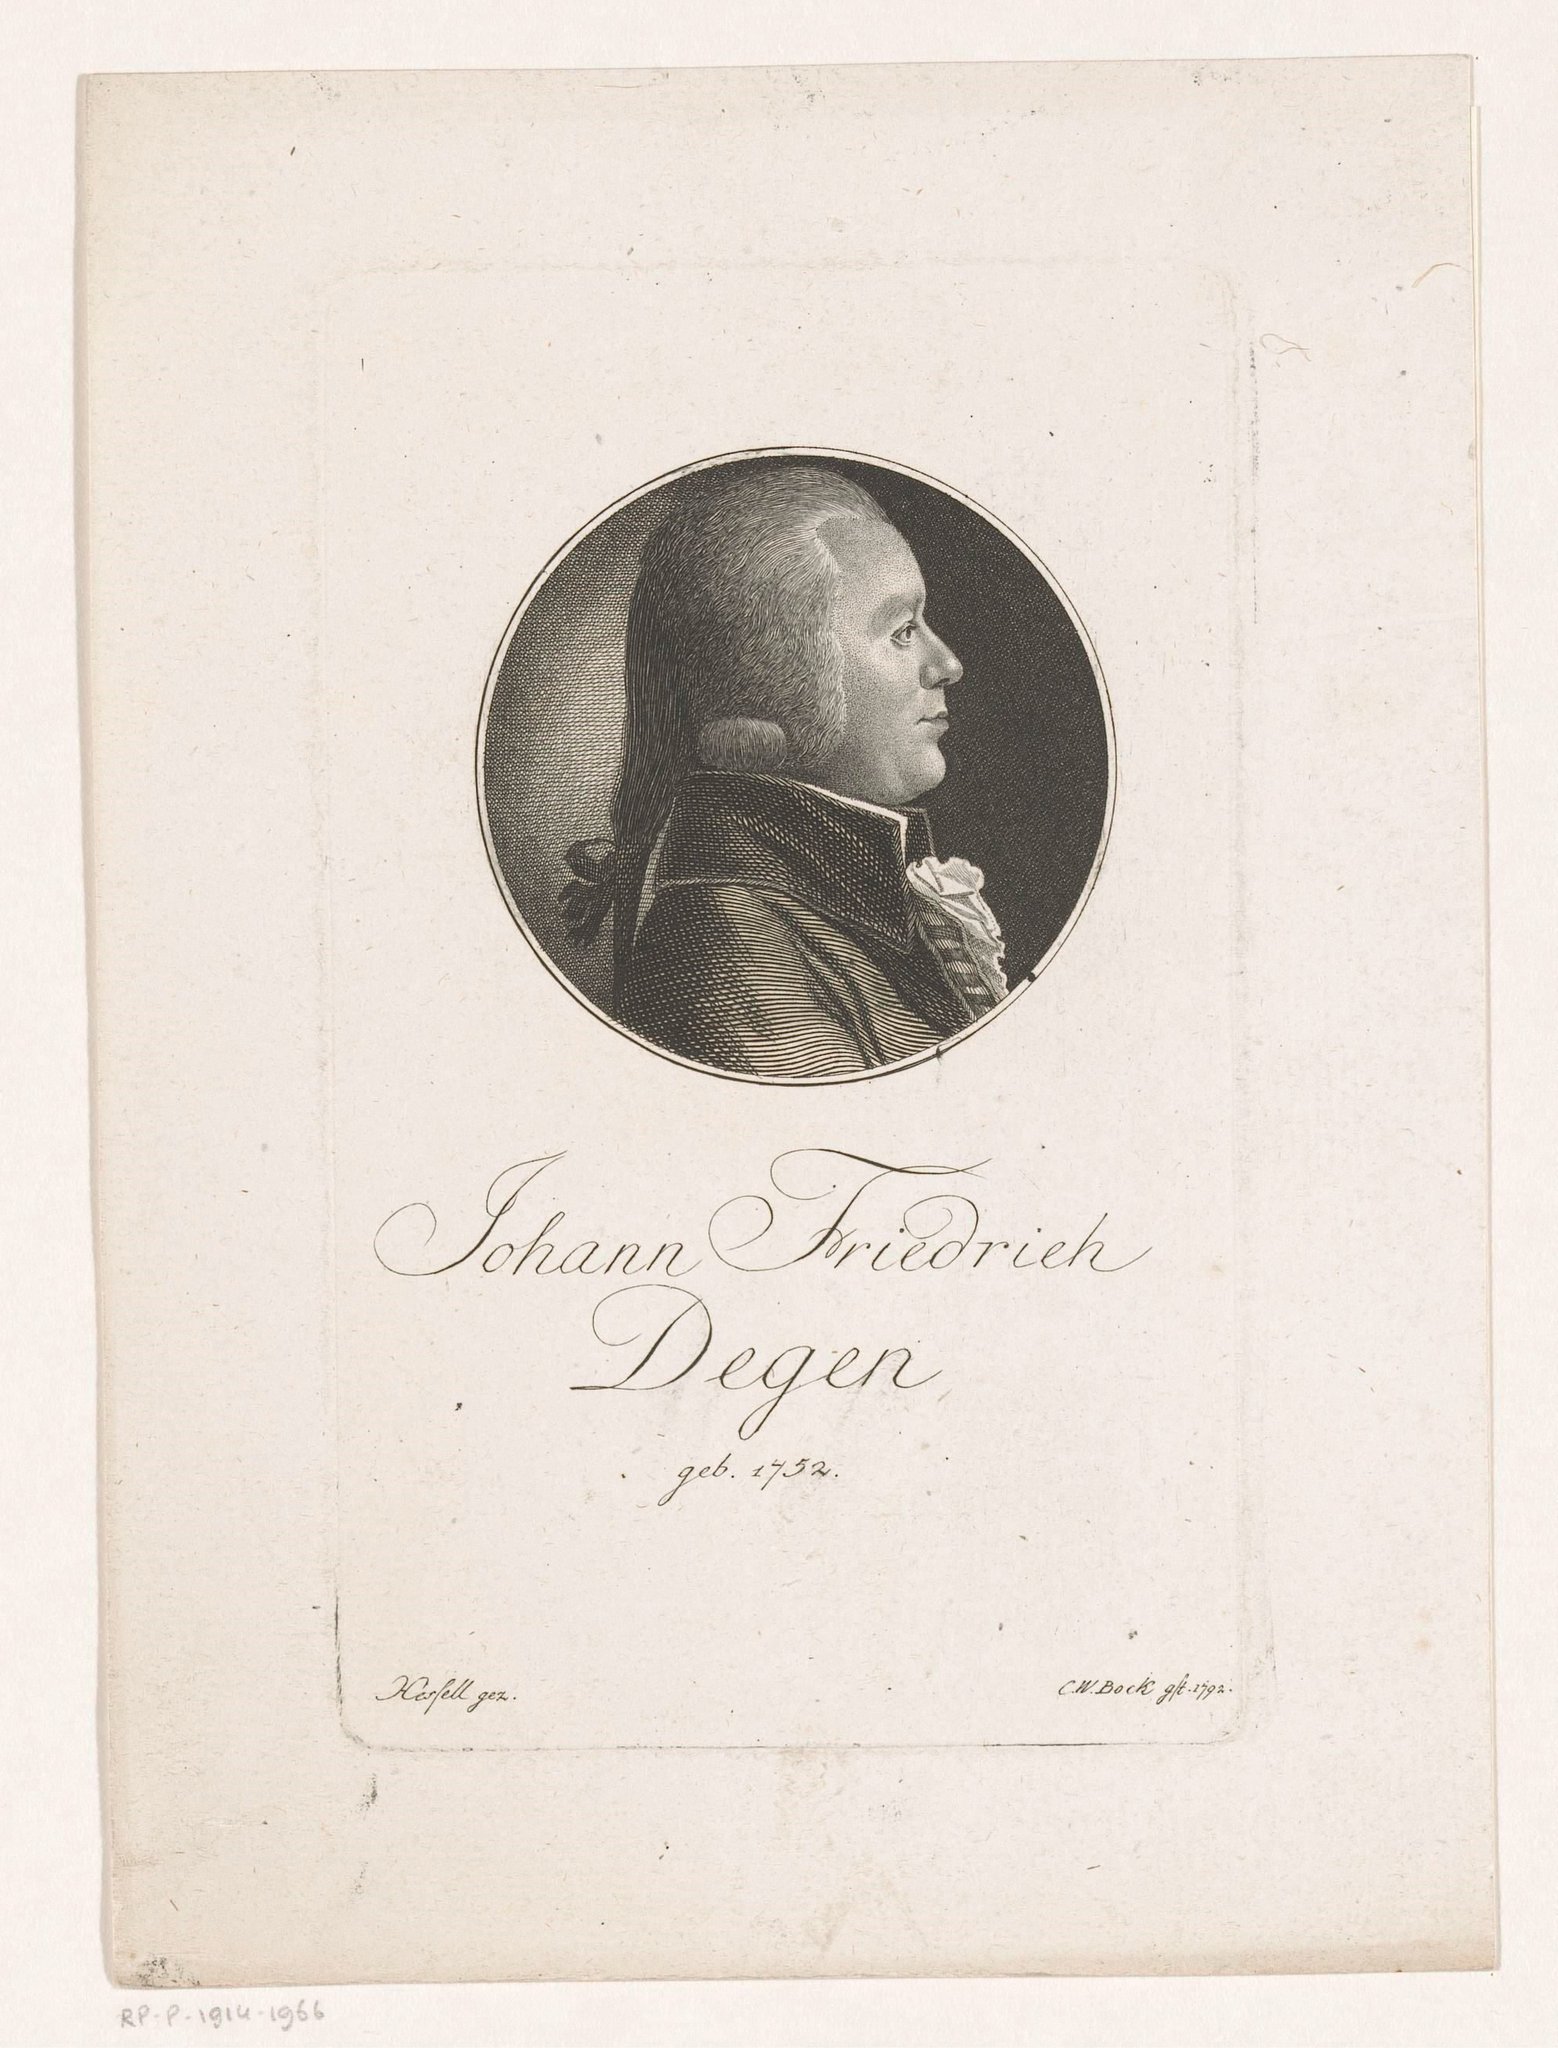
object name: print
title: Portret van Johann Friedrich Degen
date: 1792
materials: paper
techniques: engraving, etching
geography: nuremberg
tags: historical persons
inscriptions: collector's mark: Lugt 2228